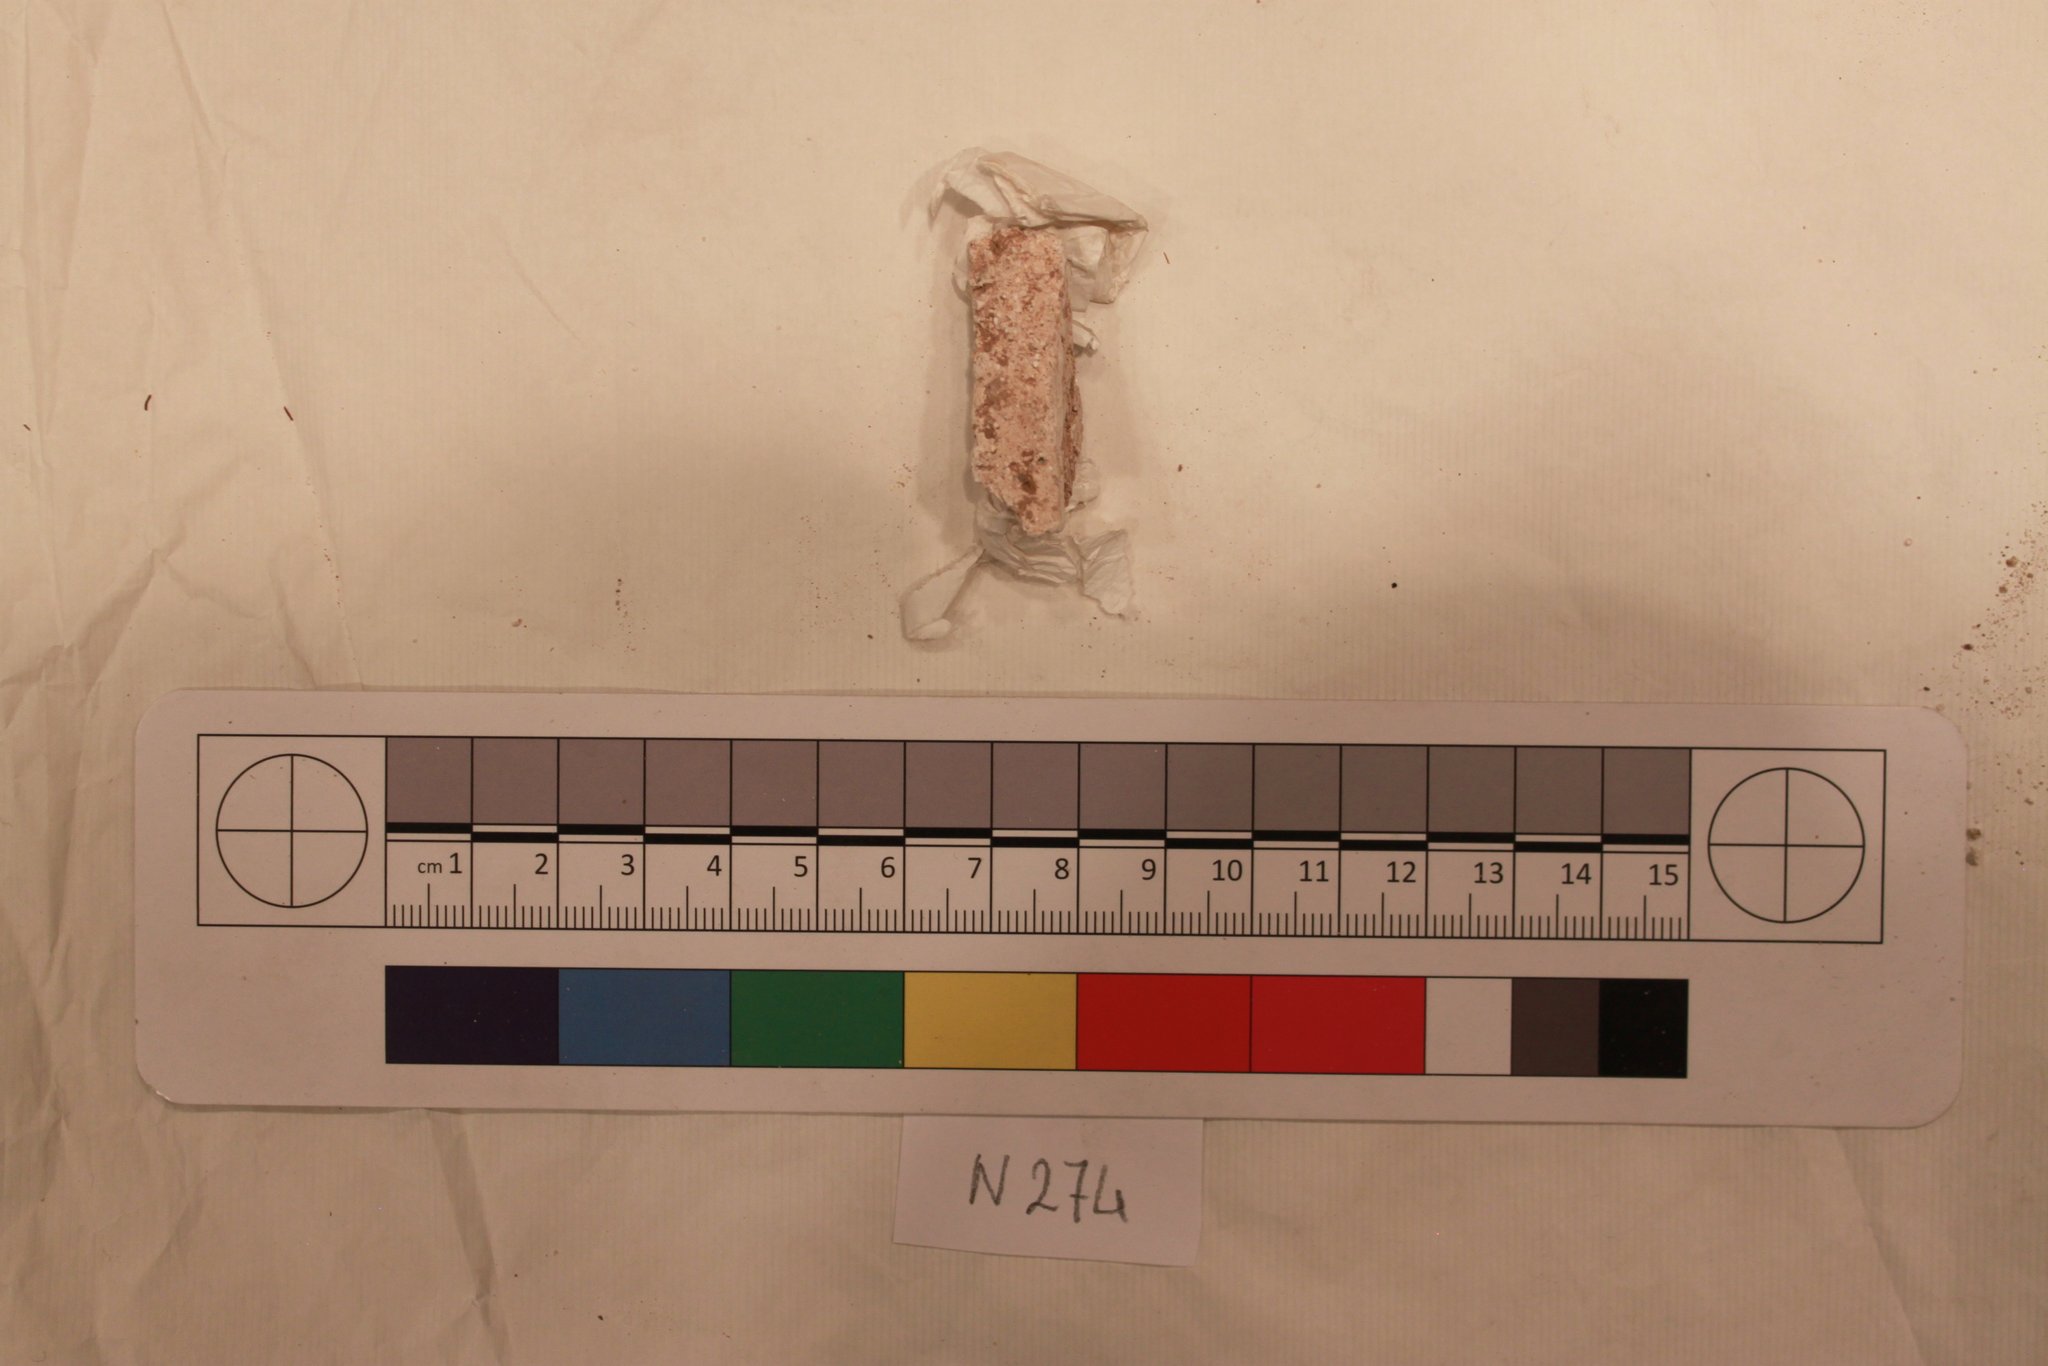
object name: fragment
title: Stucco Fragment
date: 701-1200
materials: plaster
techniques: carving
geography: iran